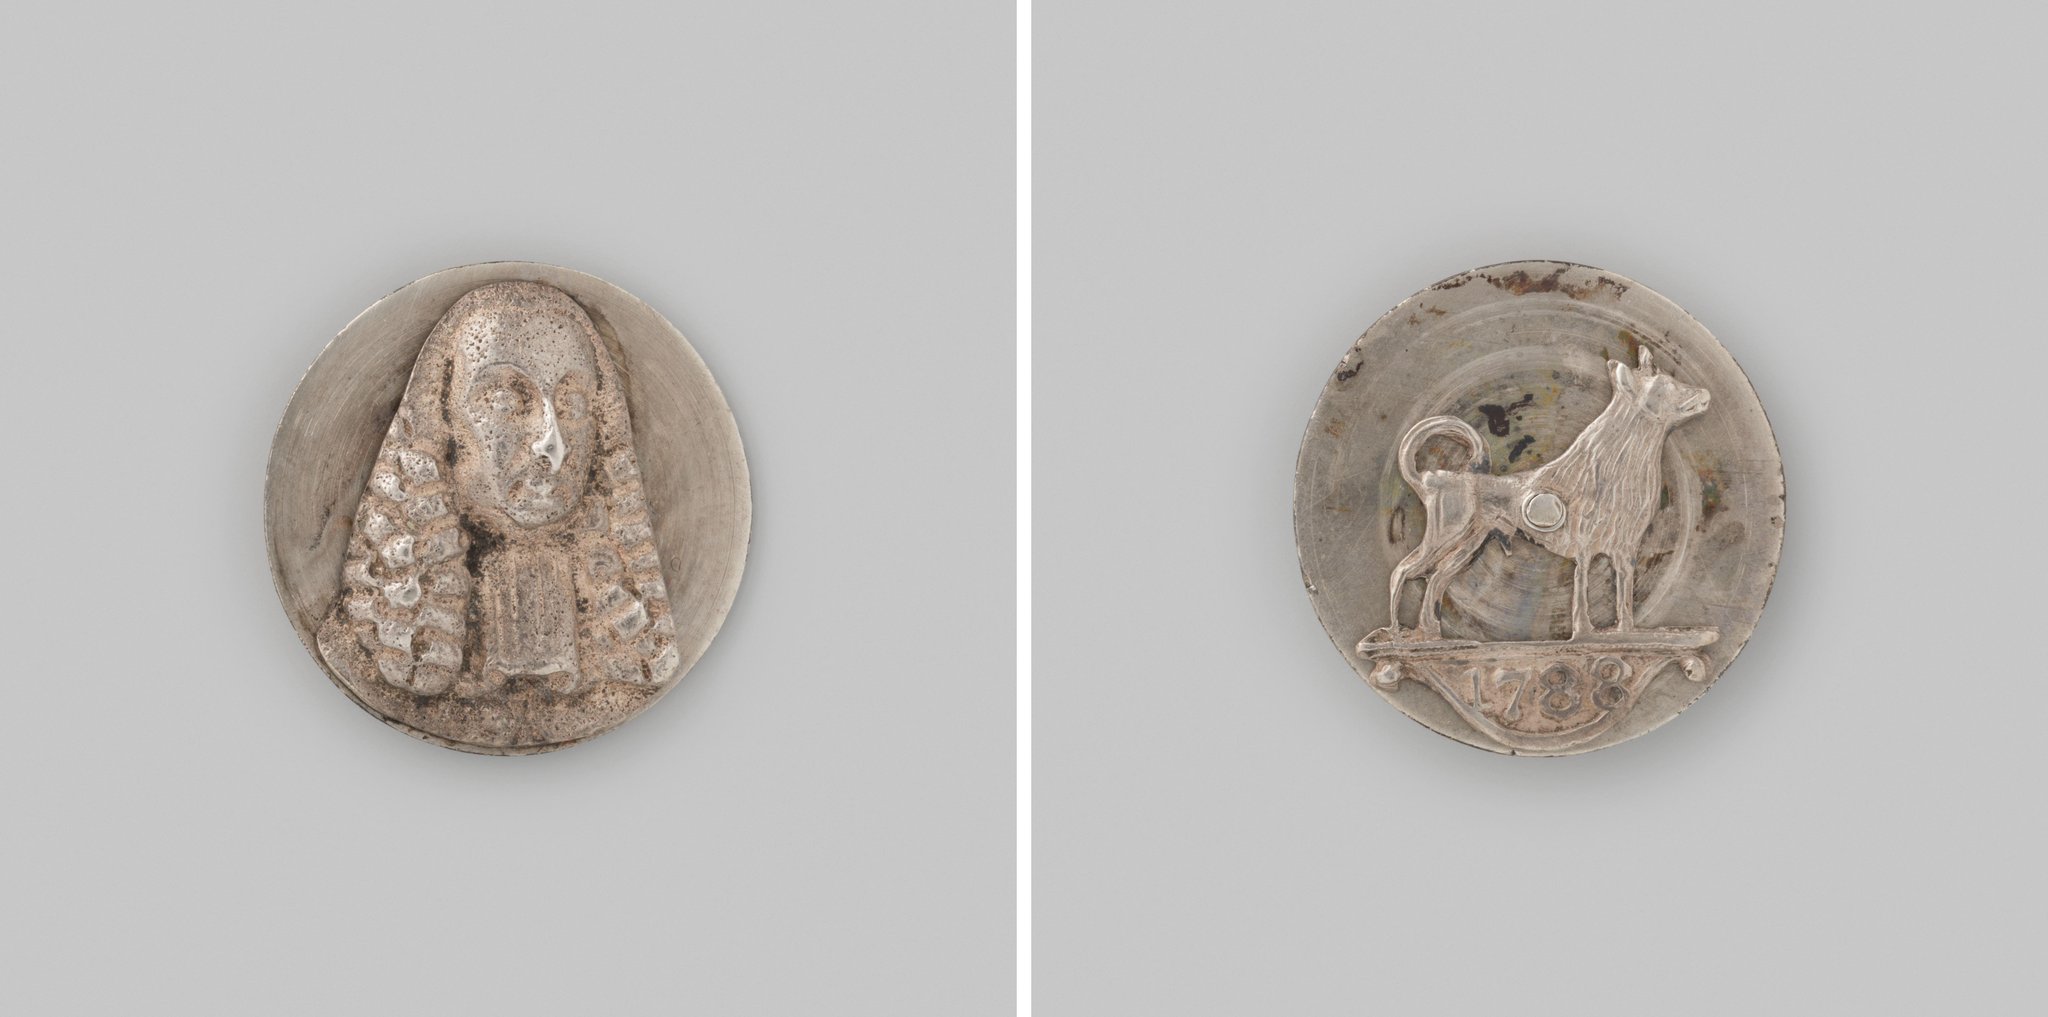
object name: insignia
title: Keeshondje, draagteken ter ere van Hendrik Danielsz. Hooft, burgemeester van Amsterdam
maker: Anonymous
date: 1788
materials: silver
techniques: fastening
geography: netherlands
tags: amsterdam, hendrik danielsz. hooft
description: Zilveren penning. Voorzijde: borststuk man. Keerzijde: hond met spitse bek, harige kop en nek met manen, glad achterlijf en lange in pluim uitlopende staart, die met lus teruggeslagen op rug hangt boven jaartal